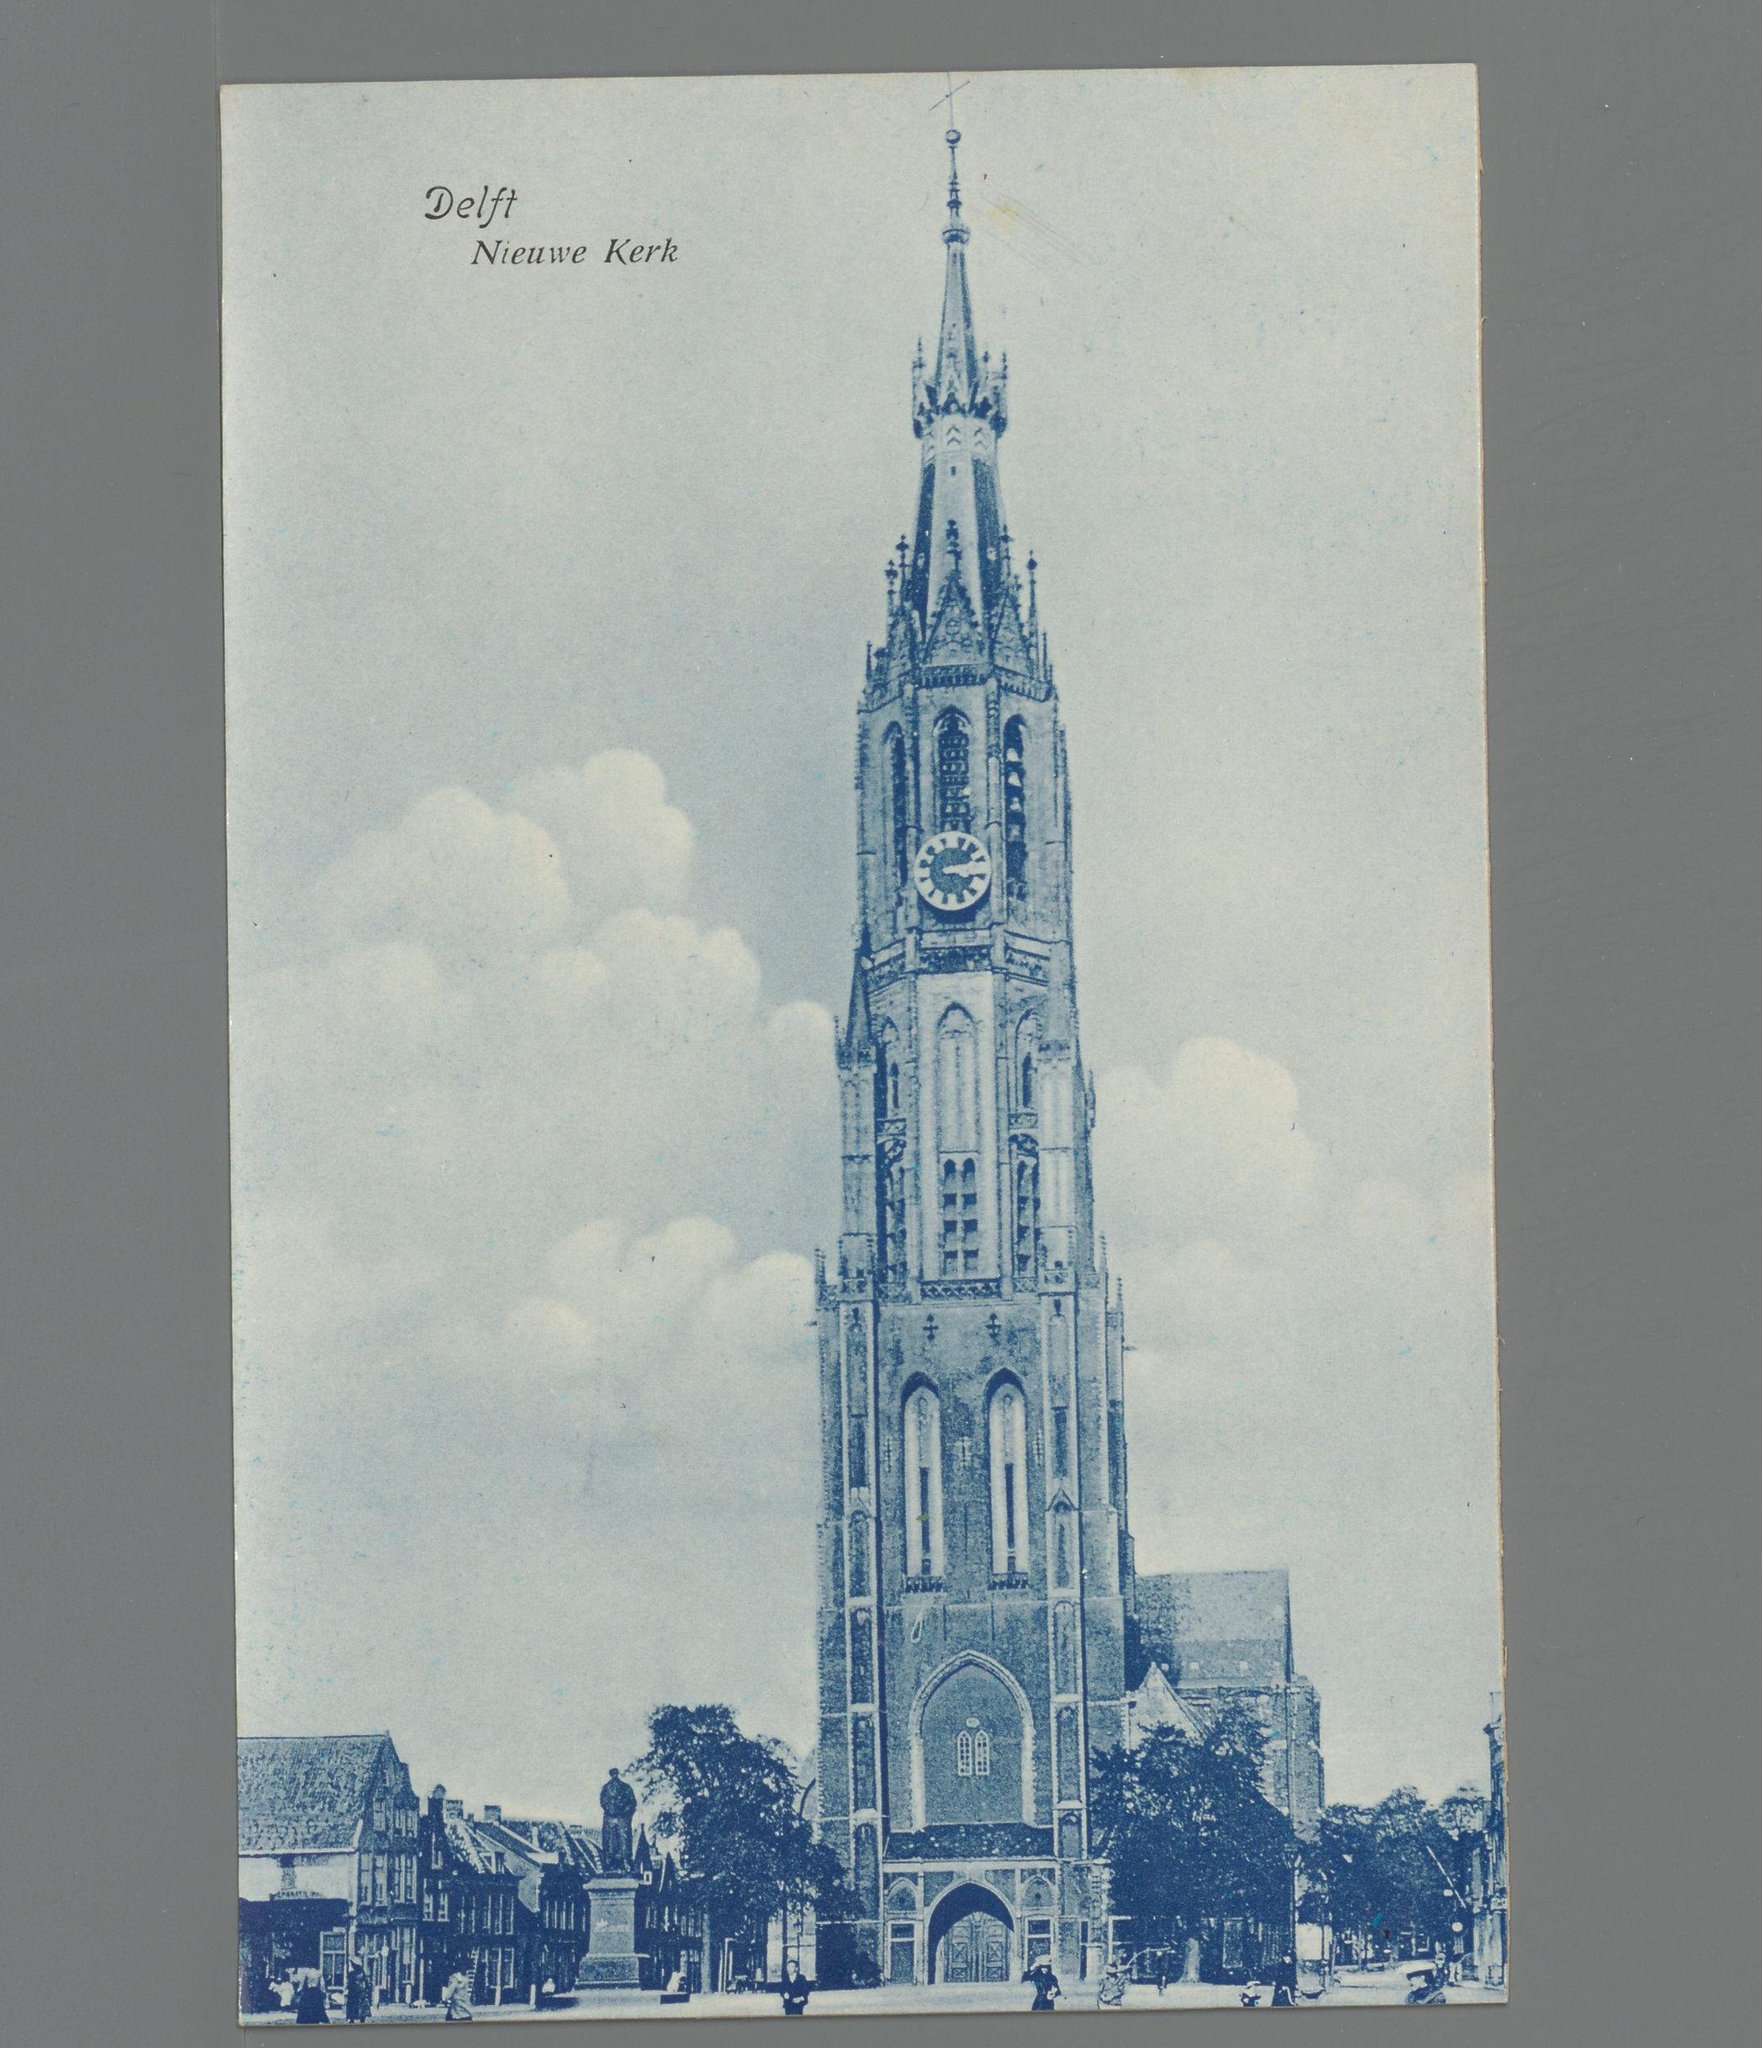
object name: ansichtkaart, prentbriefkaart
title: Delft. Nieuwe Kerk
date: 1909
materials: cardboard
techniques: photograph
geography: delft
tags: delft, hugo de groot, church (exterior), monument, statue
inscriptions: date